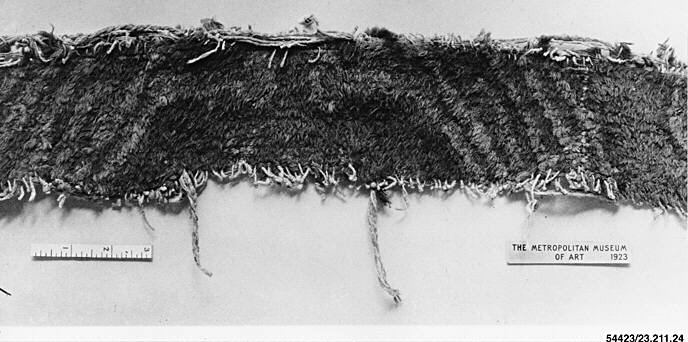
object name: rug fragment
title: Fragment of Rug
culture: chinese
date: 1701-1800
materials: cotton, wool